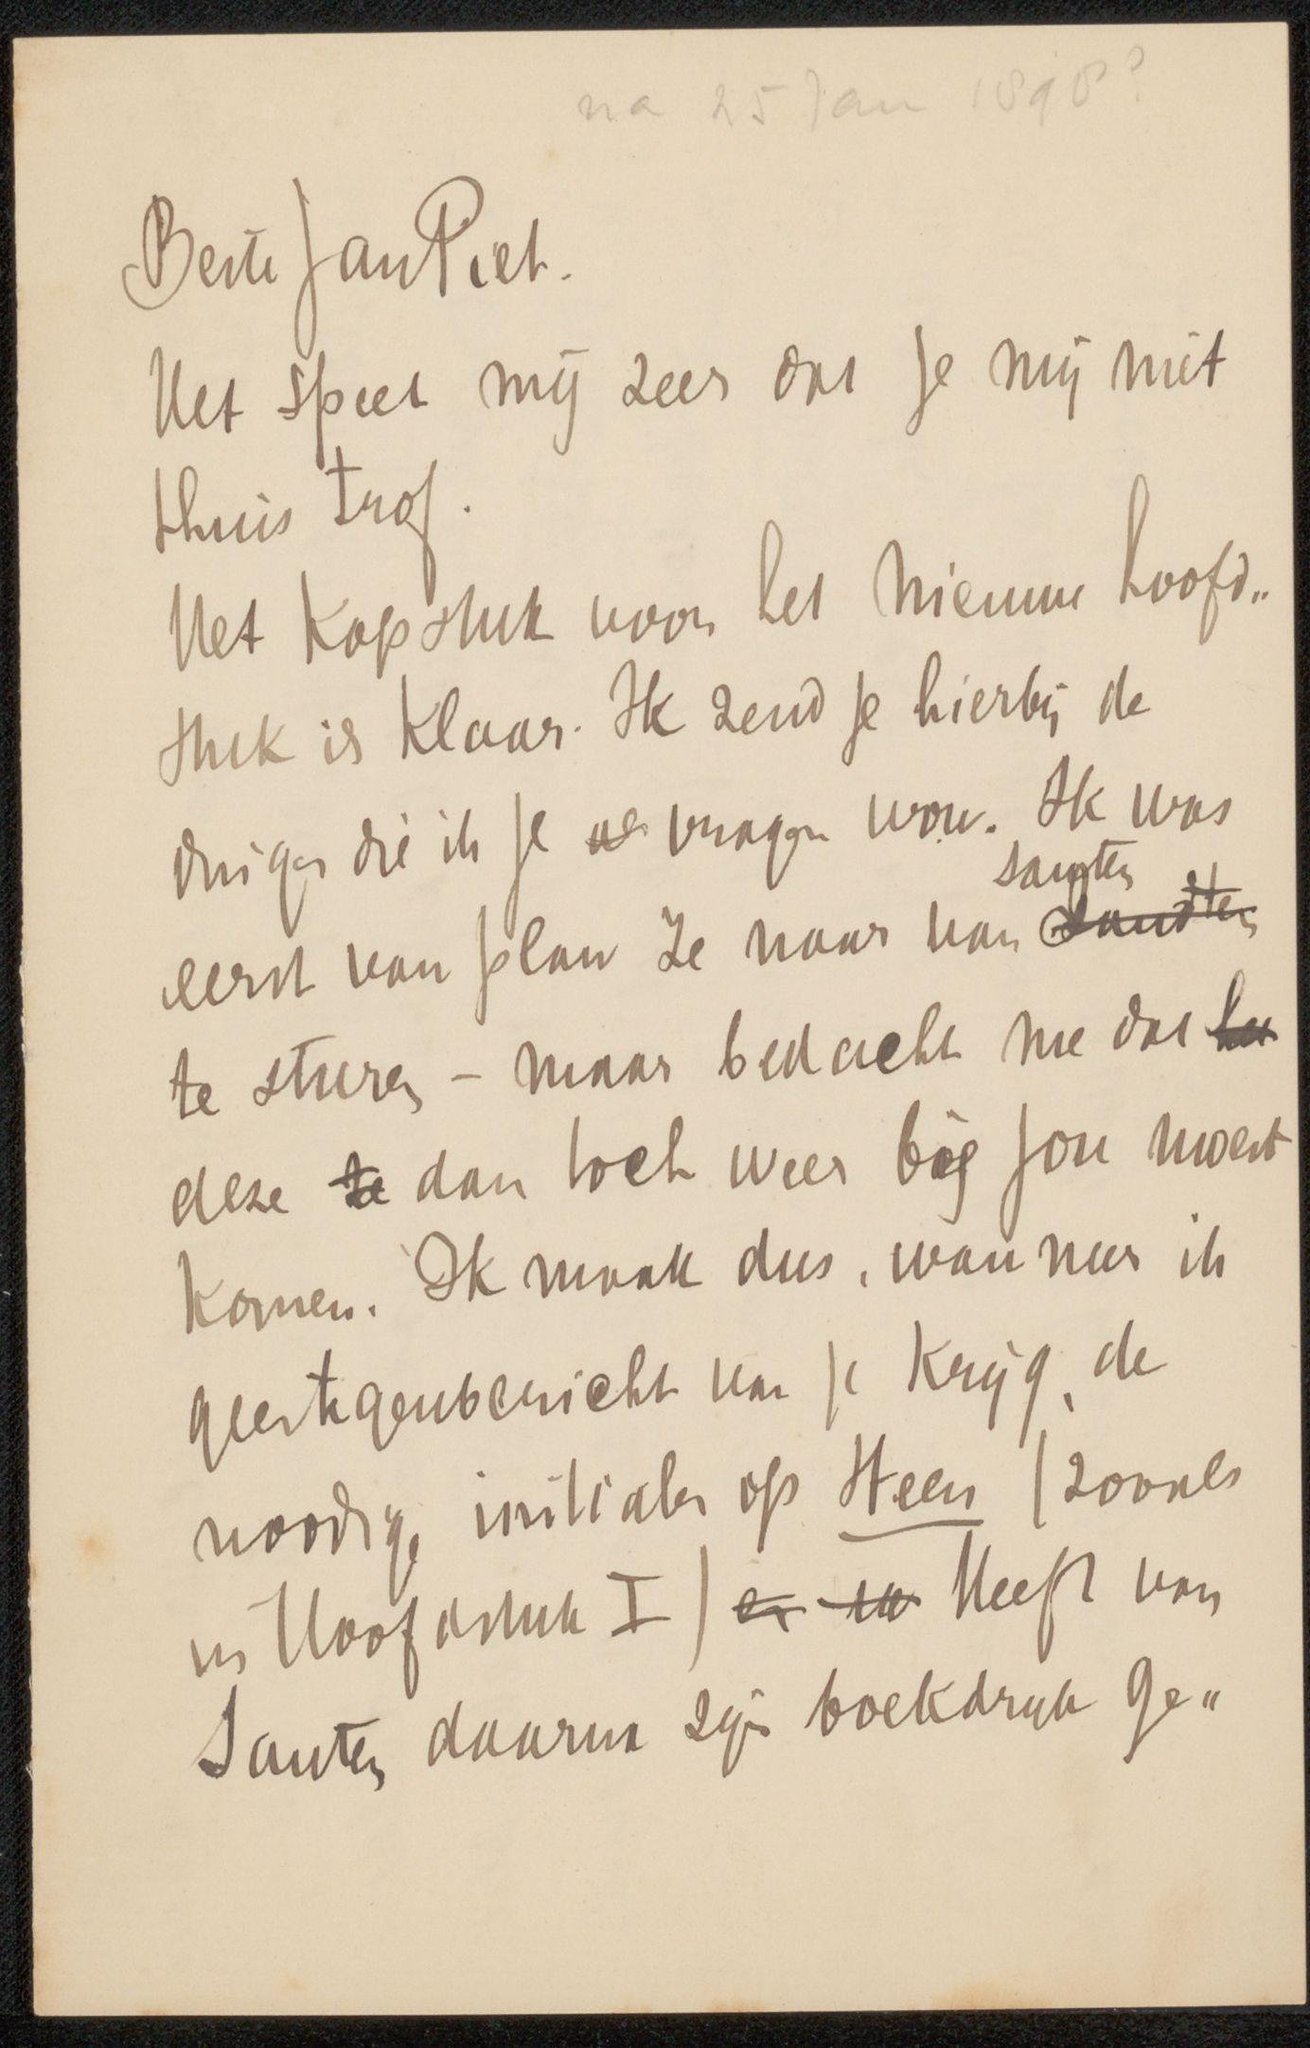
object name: letter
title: Brief aan Jan Veth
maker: antoon derkinderen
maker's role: draughtsman, painter, print maker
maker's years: 1859-1925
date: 1874-1925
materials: ink, paper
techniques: pen, writing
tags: dordrecht, amsterdam, print maker, jan veth, the hague, hendrik petrus berlage, albert verwey, richard nicolaüs roland holst, painter, draughtsman, designer, jan verkade, painting (including book-illumination, miniature-painting), architecture, printed matter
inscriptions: collector's mark: ‘RPK’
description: Brief gedateerd na 25 Jan 1898? in latere hand.